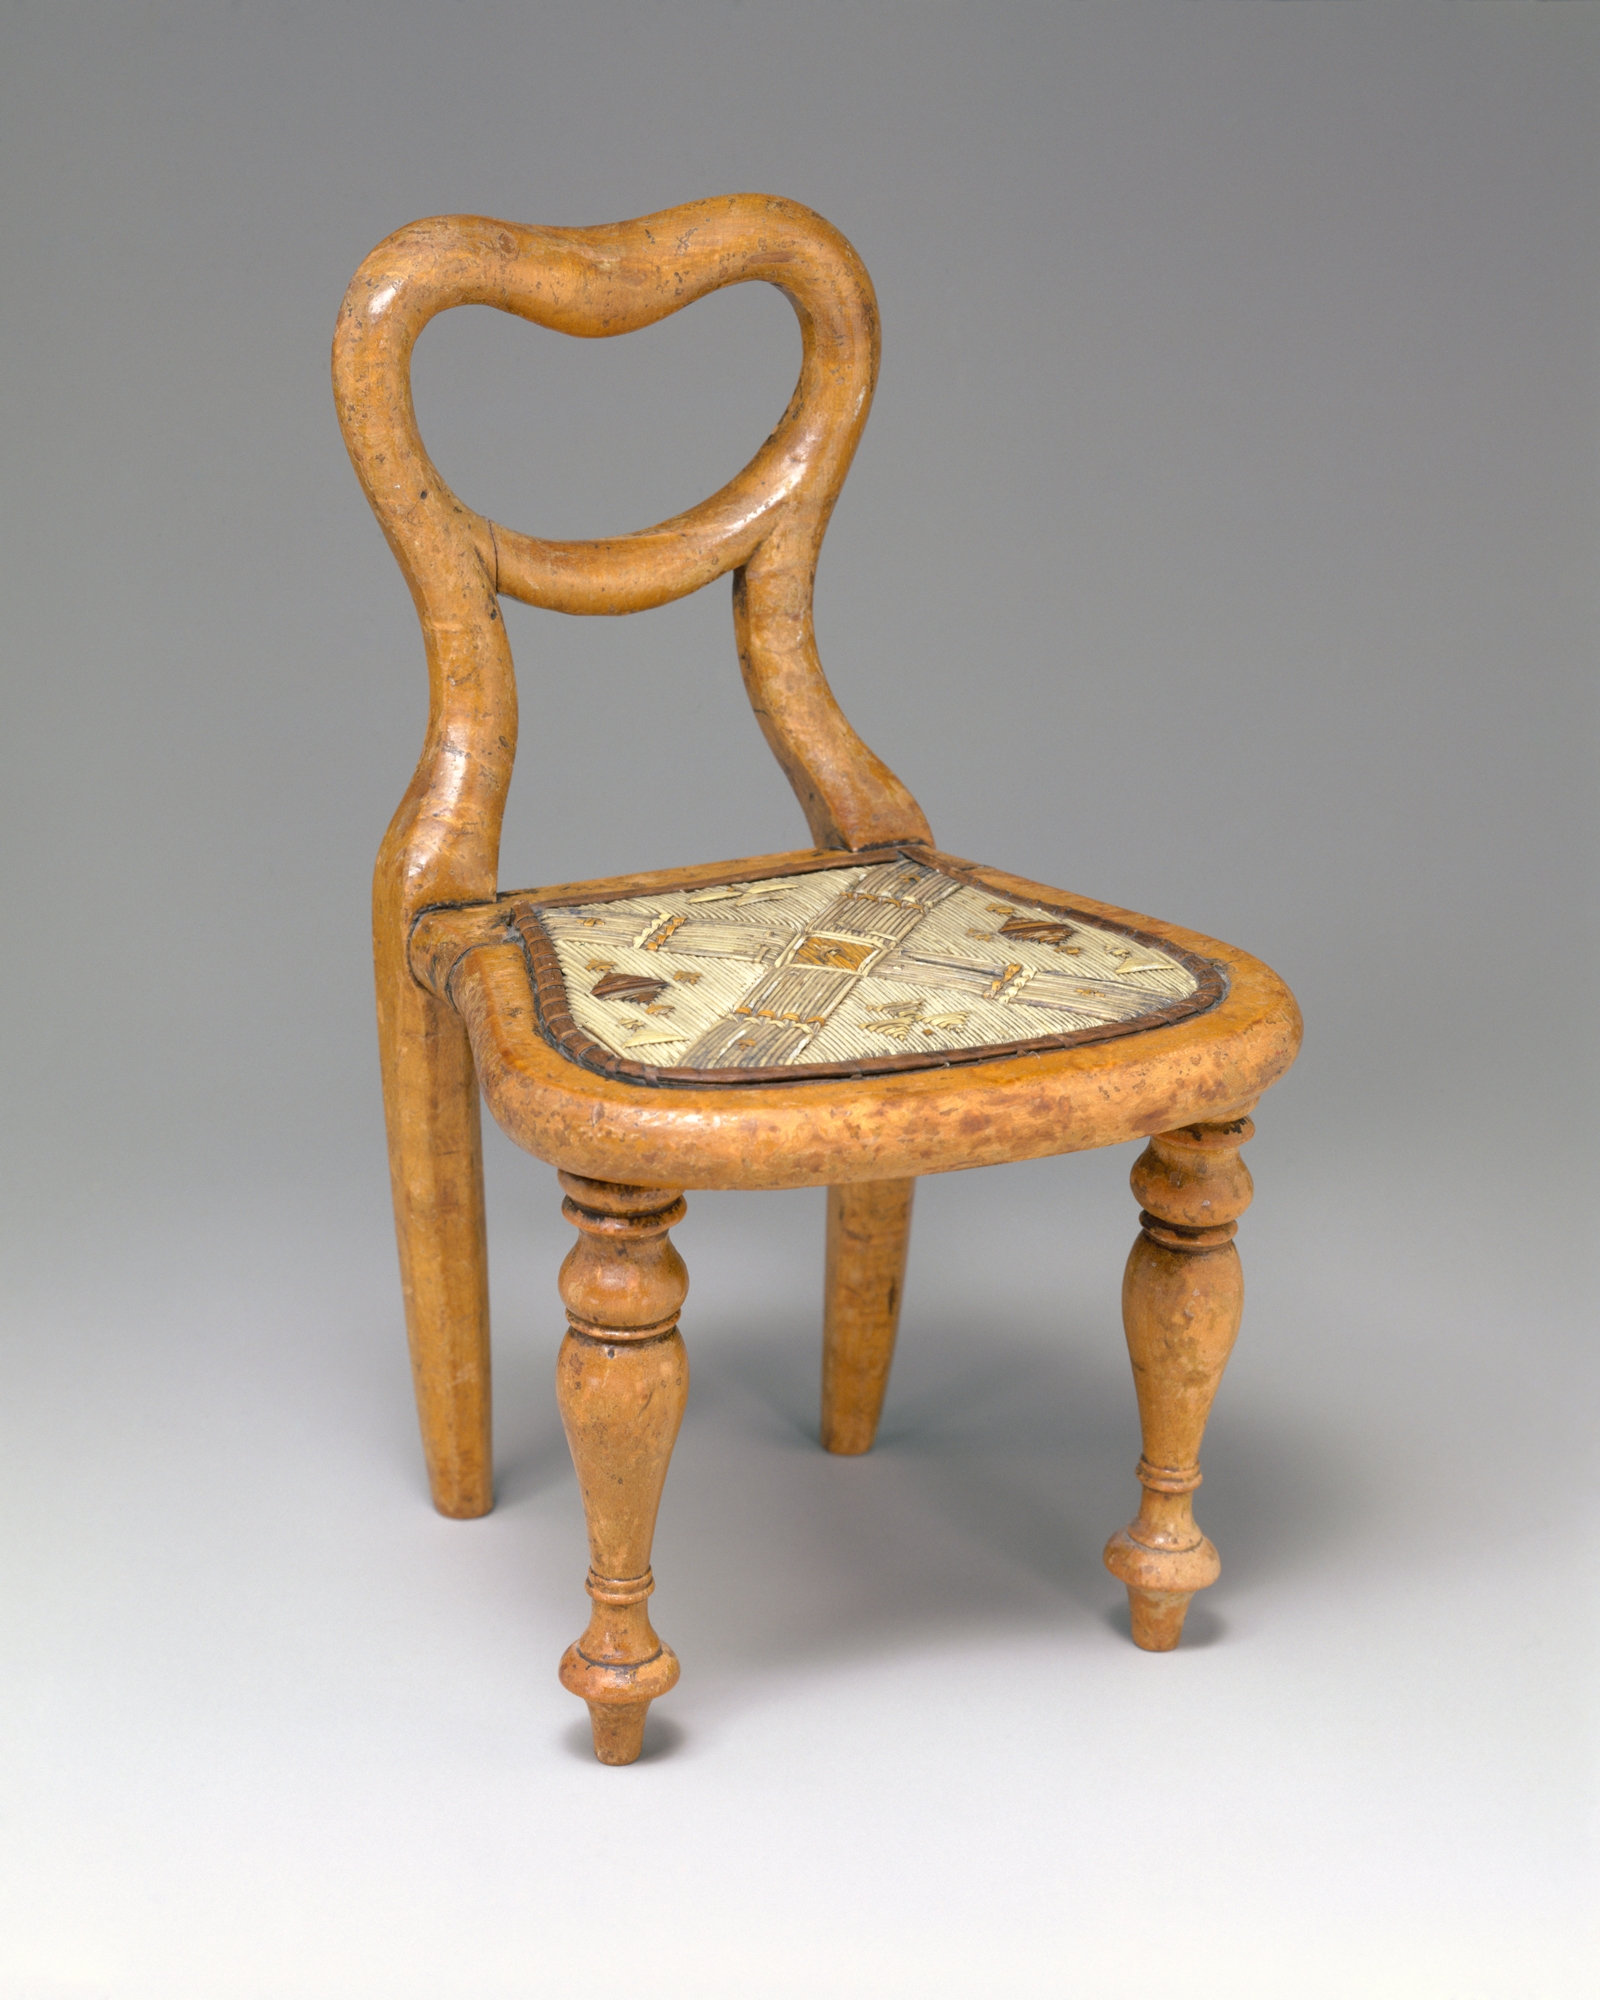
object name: miniature chair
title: Dollhouse Chair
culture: micmac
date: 1860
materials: wood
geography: canada